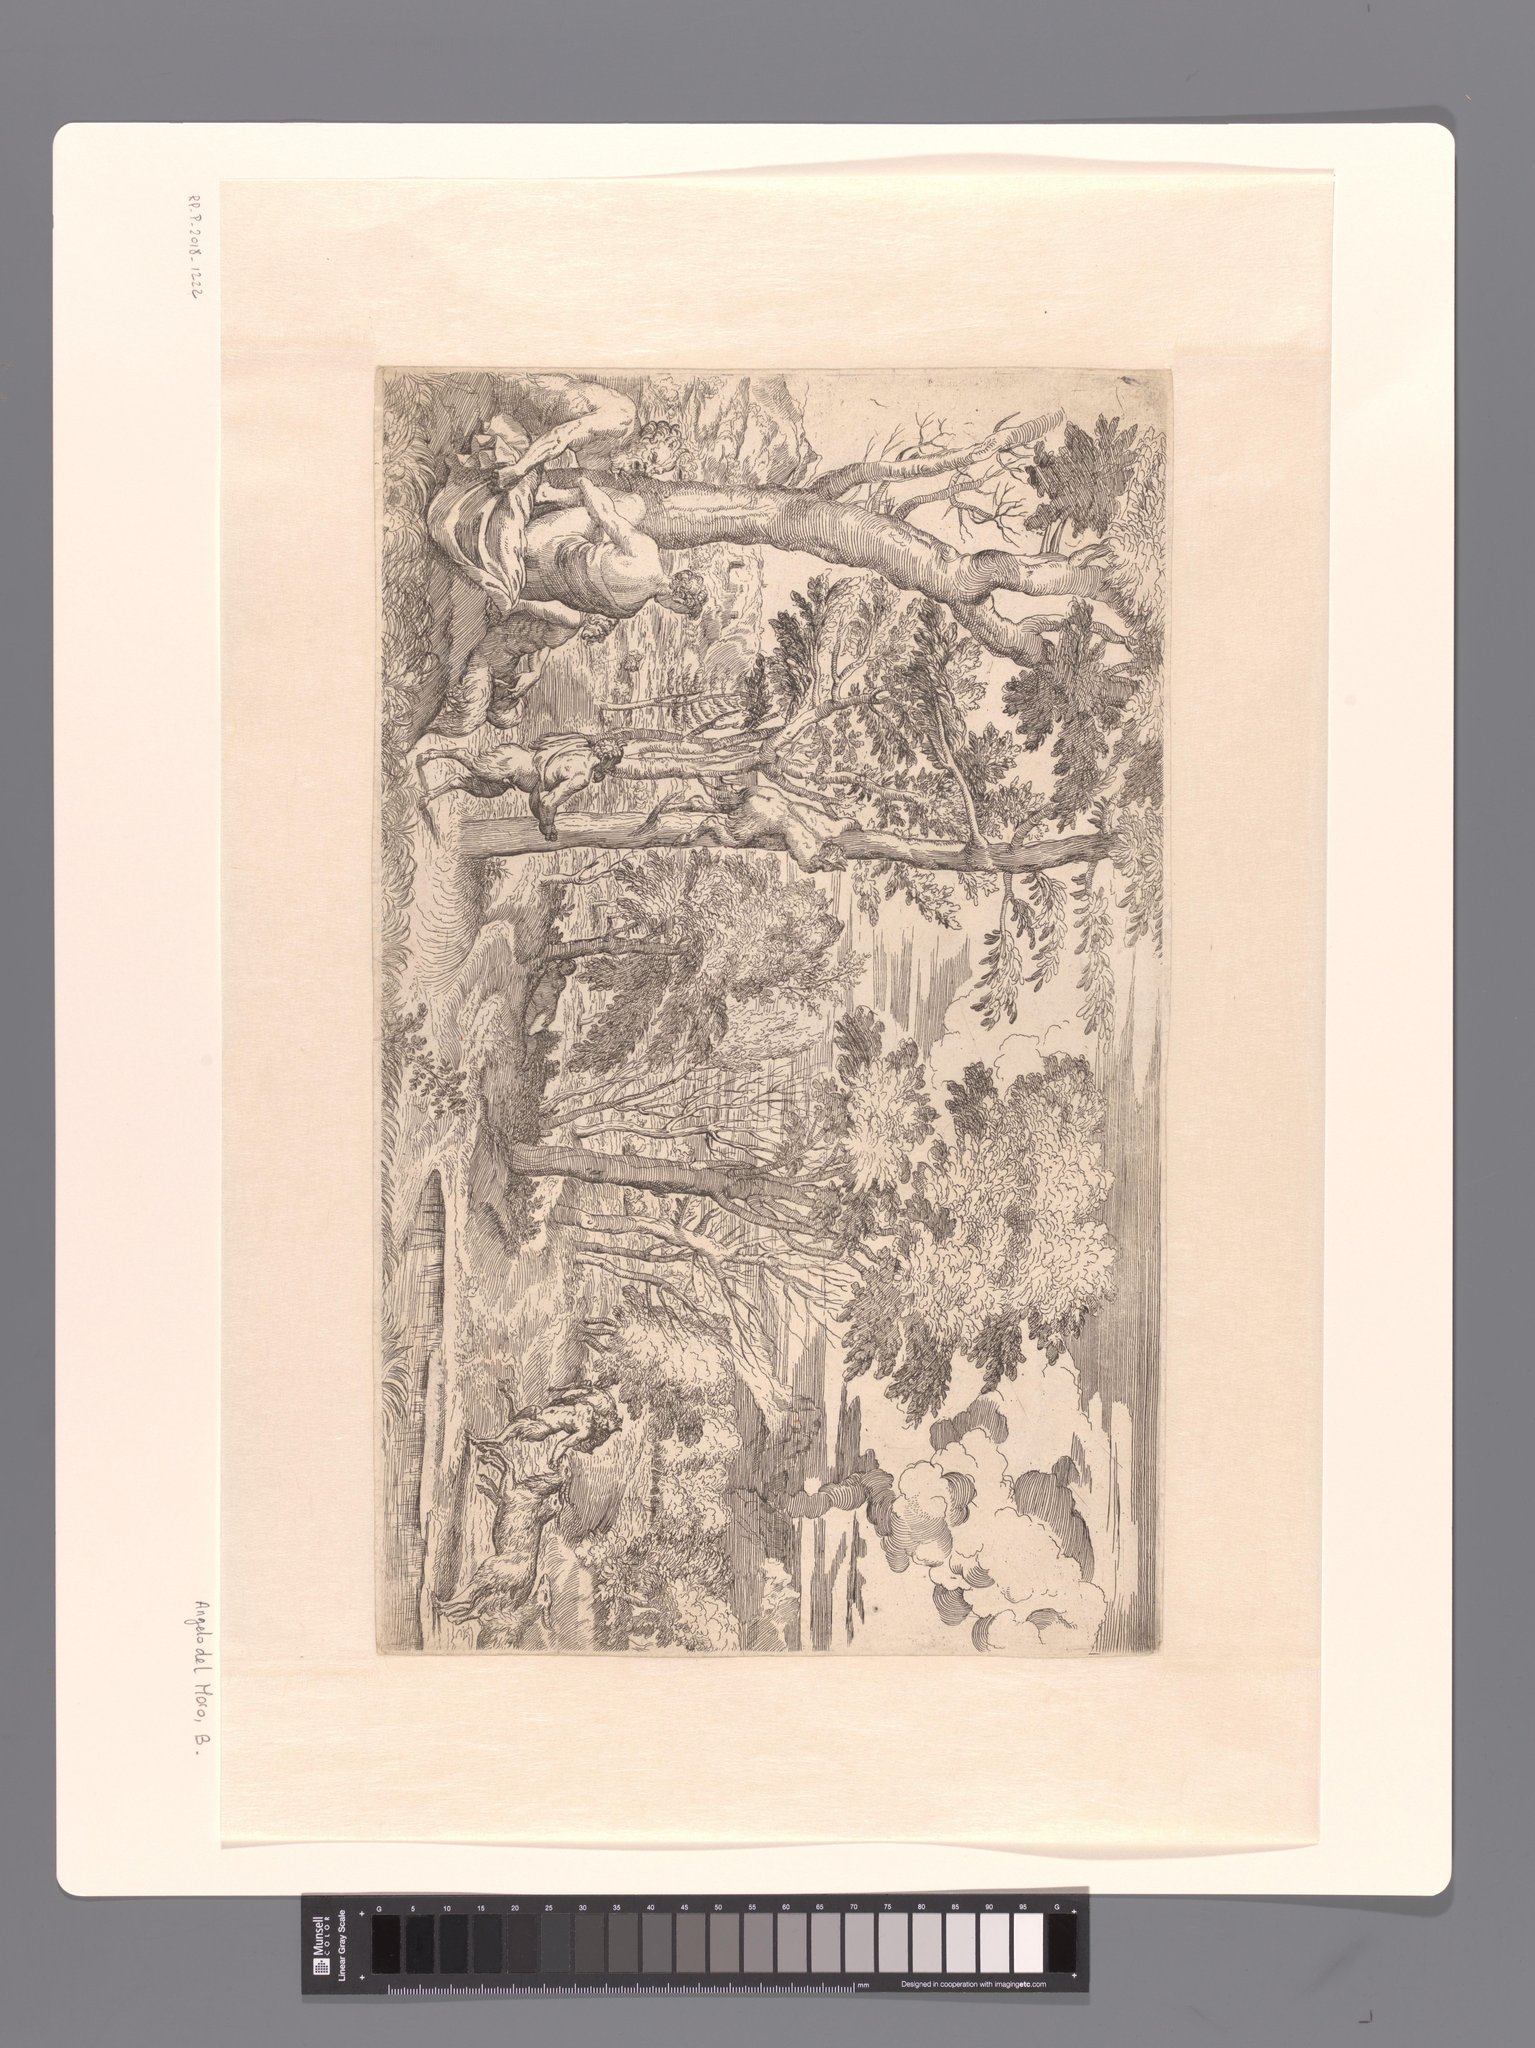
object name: print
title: Landschap met saters en nimfen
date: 1560-1570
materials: paper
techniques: etching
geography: venice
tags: nymphs (in general); 'ninfe in commune' (ripa), satyr(s) spying upon, forest, wood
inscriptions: collector's mark: Lugt 2760, collector's mark: Lugt 2228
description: Boomrijk landschap met nimfen en saters. Een sater is in een boom geklommen om een nimf te bespieden.